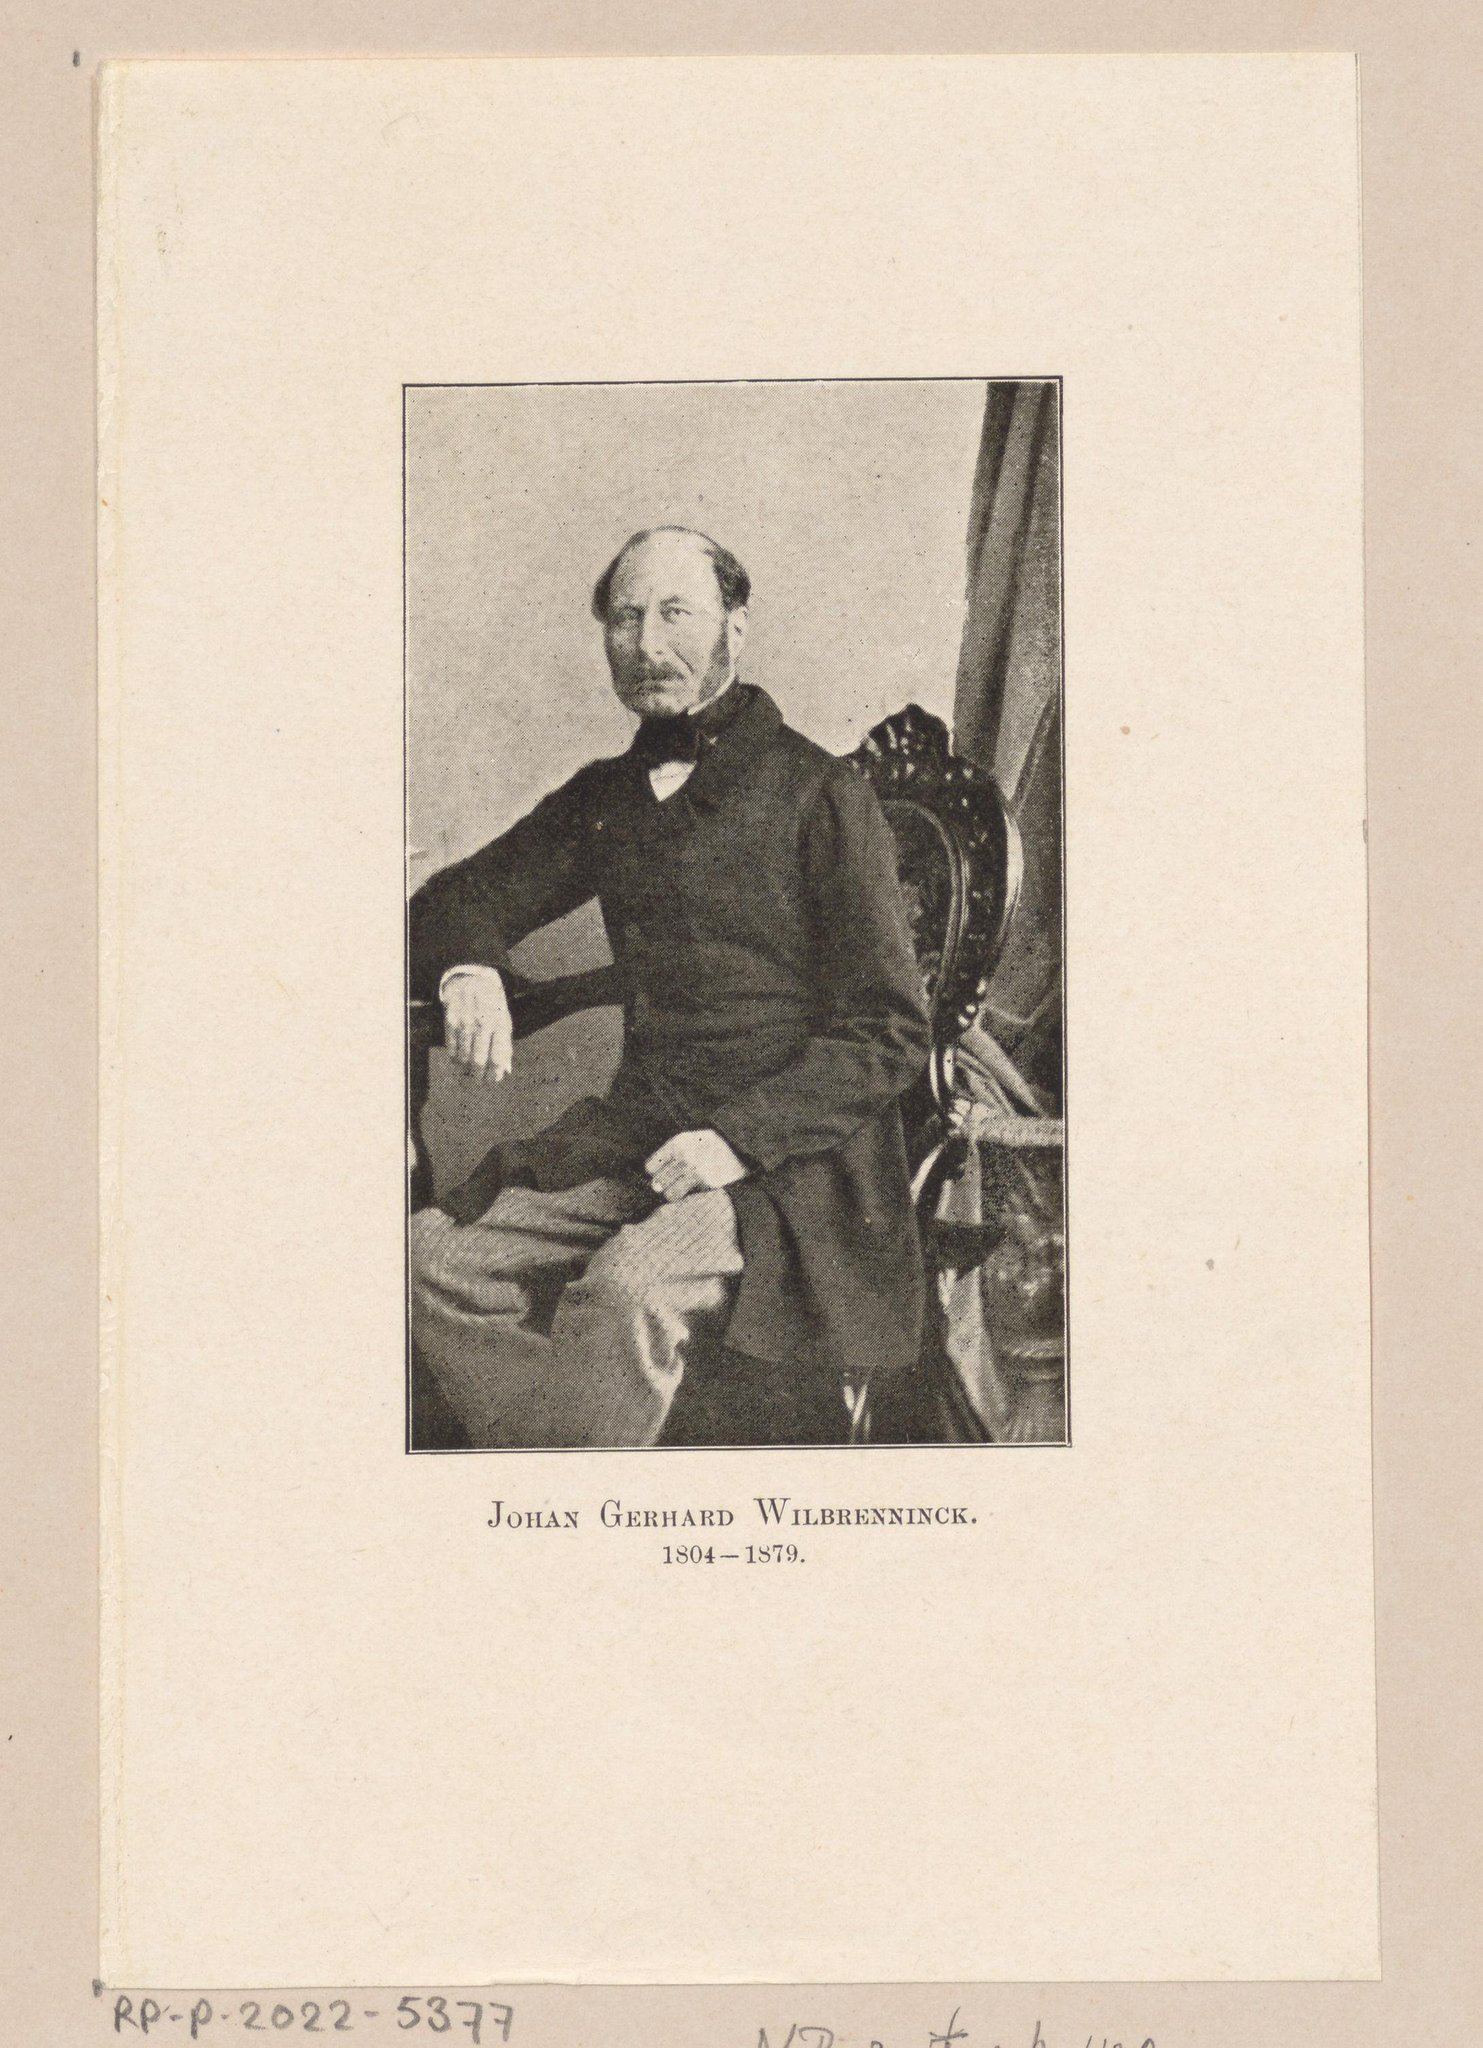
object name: photomechanical print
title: Portret van Johan Gerhard Wilbrenninck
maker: Anonymous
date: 1912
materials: paper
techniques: letterpress printing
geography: netherlands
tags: deventer, historical persons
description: Prent waarschijnlijk uit: Nederland's patriciaat, dl. 3., 1912, p. 432.